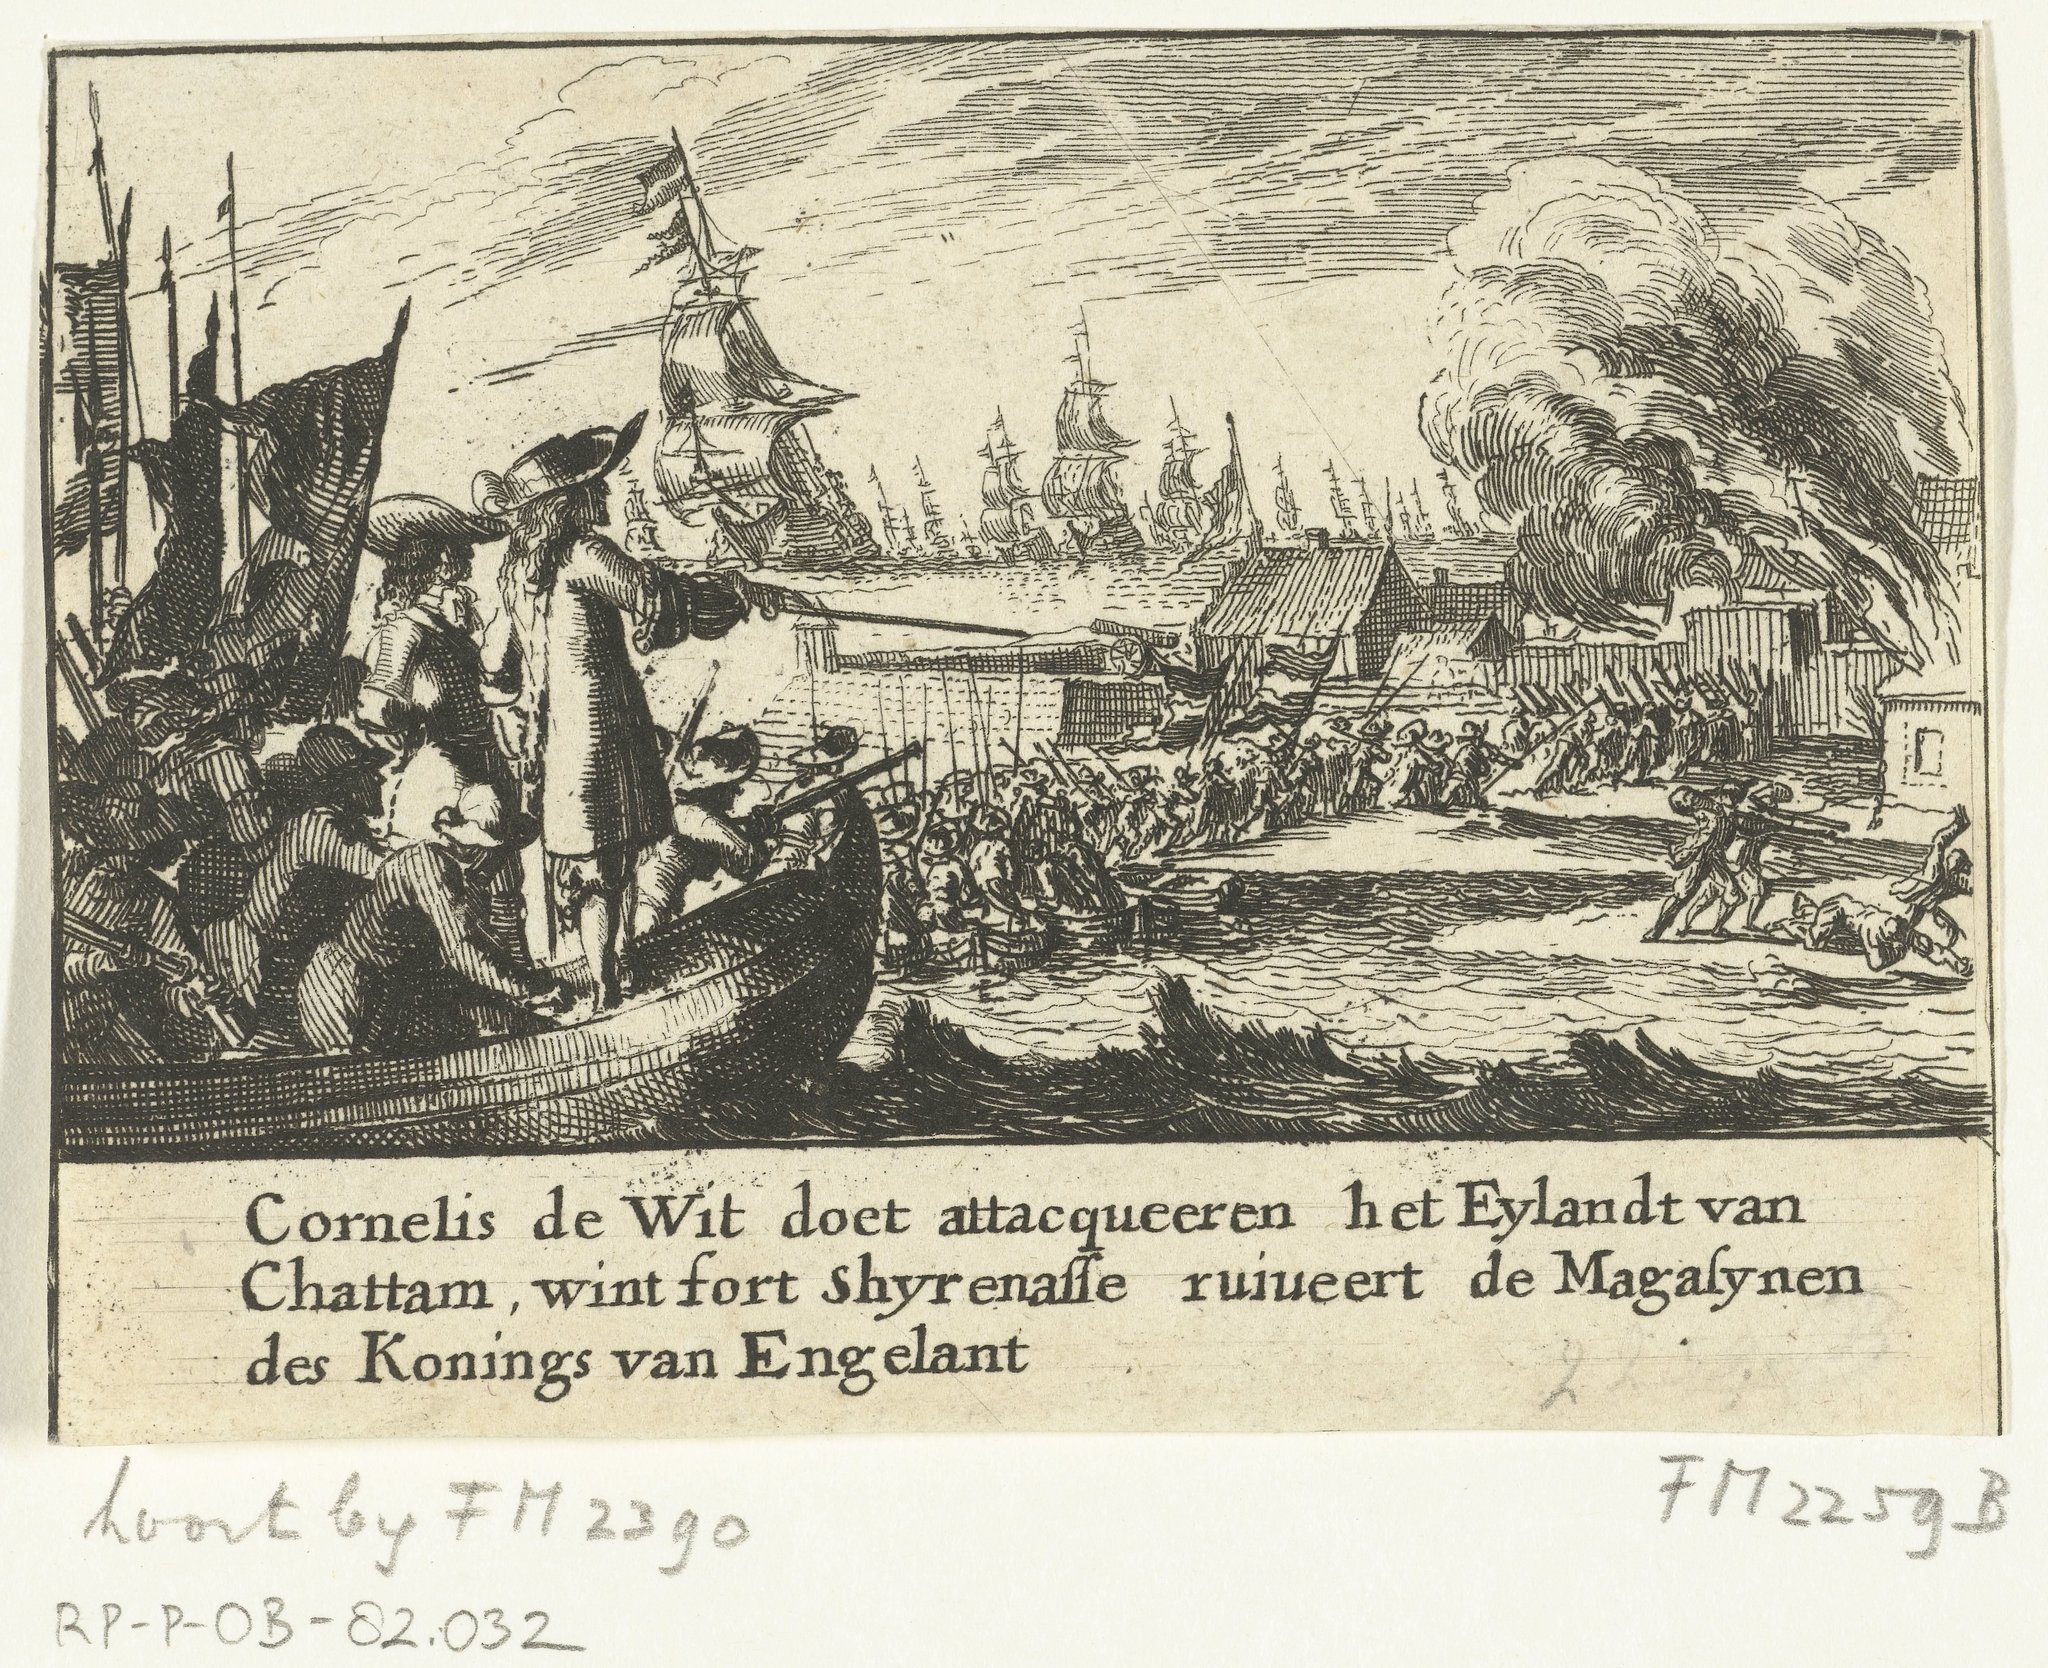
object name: print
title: Cornelis de Witt leidt de aanval op Sheerness, 1667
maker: romeyn de hooghe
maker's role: draughtsman, goldsmith, painter, print maker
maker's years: 1645-1708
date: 1675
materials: paper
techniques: etching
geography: northern netherlands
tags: dordrecht, the hague, cornelis de witt, capture of city (after the siege), raid on the medway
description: Cornelis de Witt leidt de aanval op Sheerness, 20-23 juni 1667. Episode uit de Tocht naar Chatham tijdens de Tweede Engelse Oorlog. Fragment van de grote prent over de gebroeders De Witt: Witten Wonder Spiegel (1675).